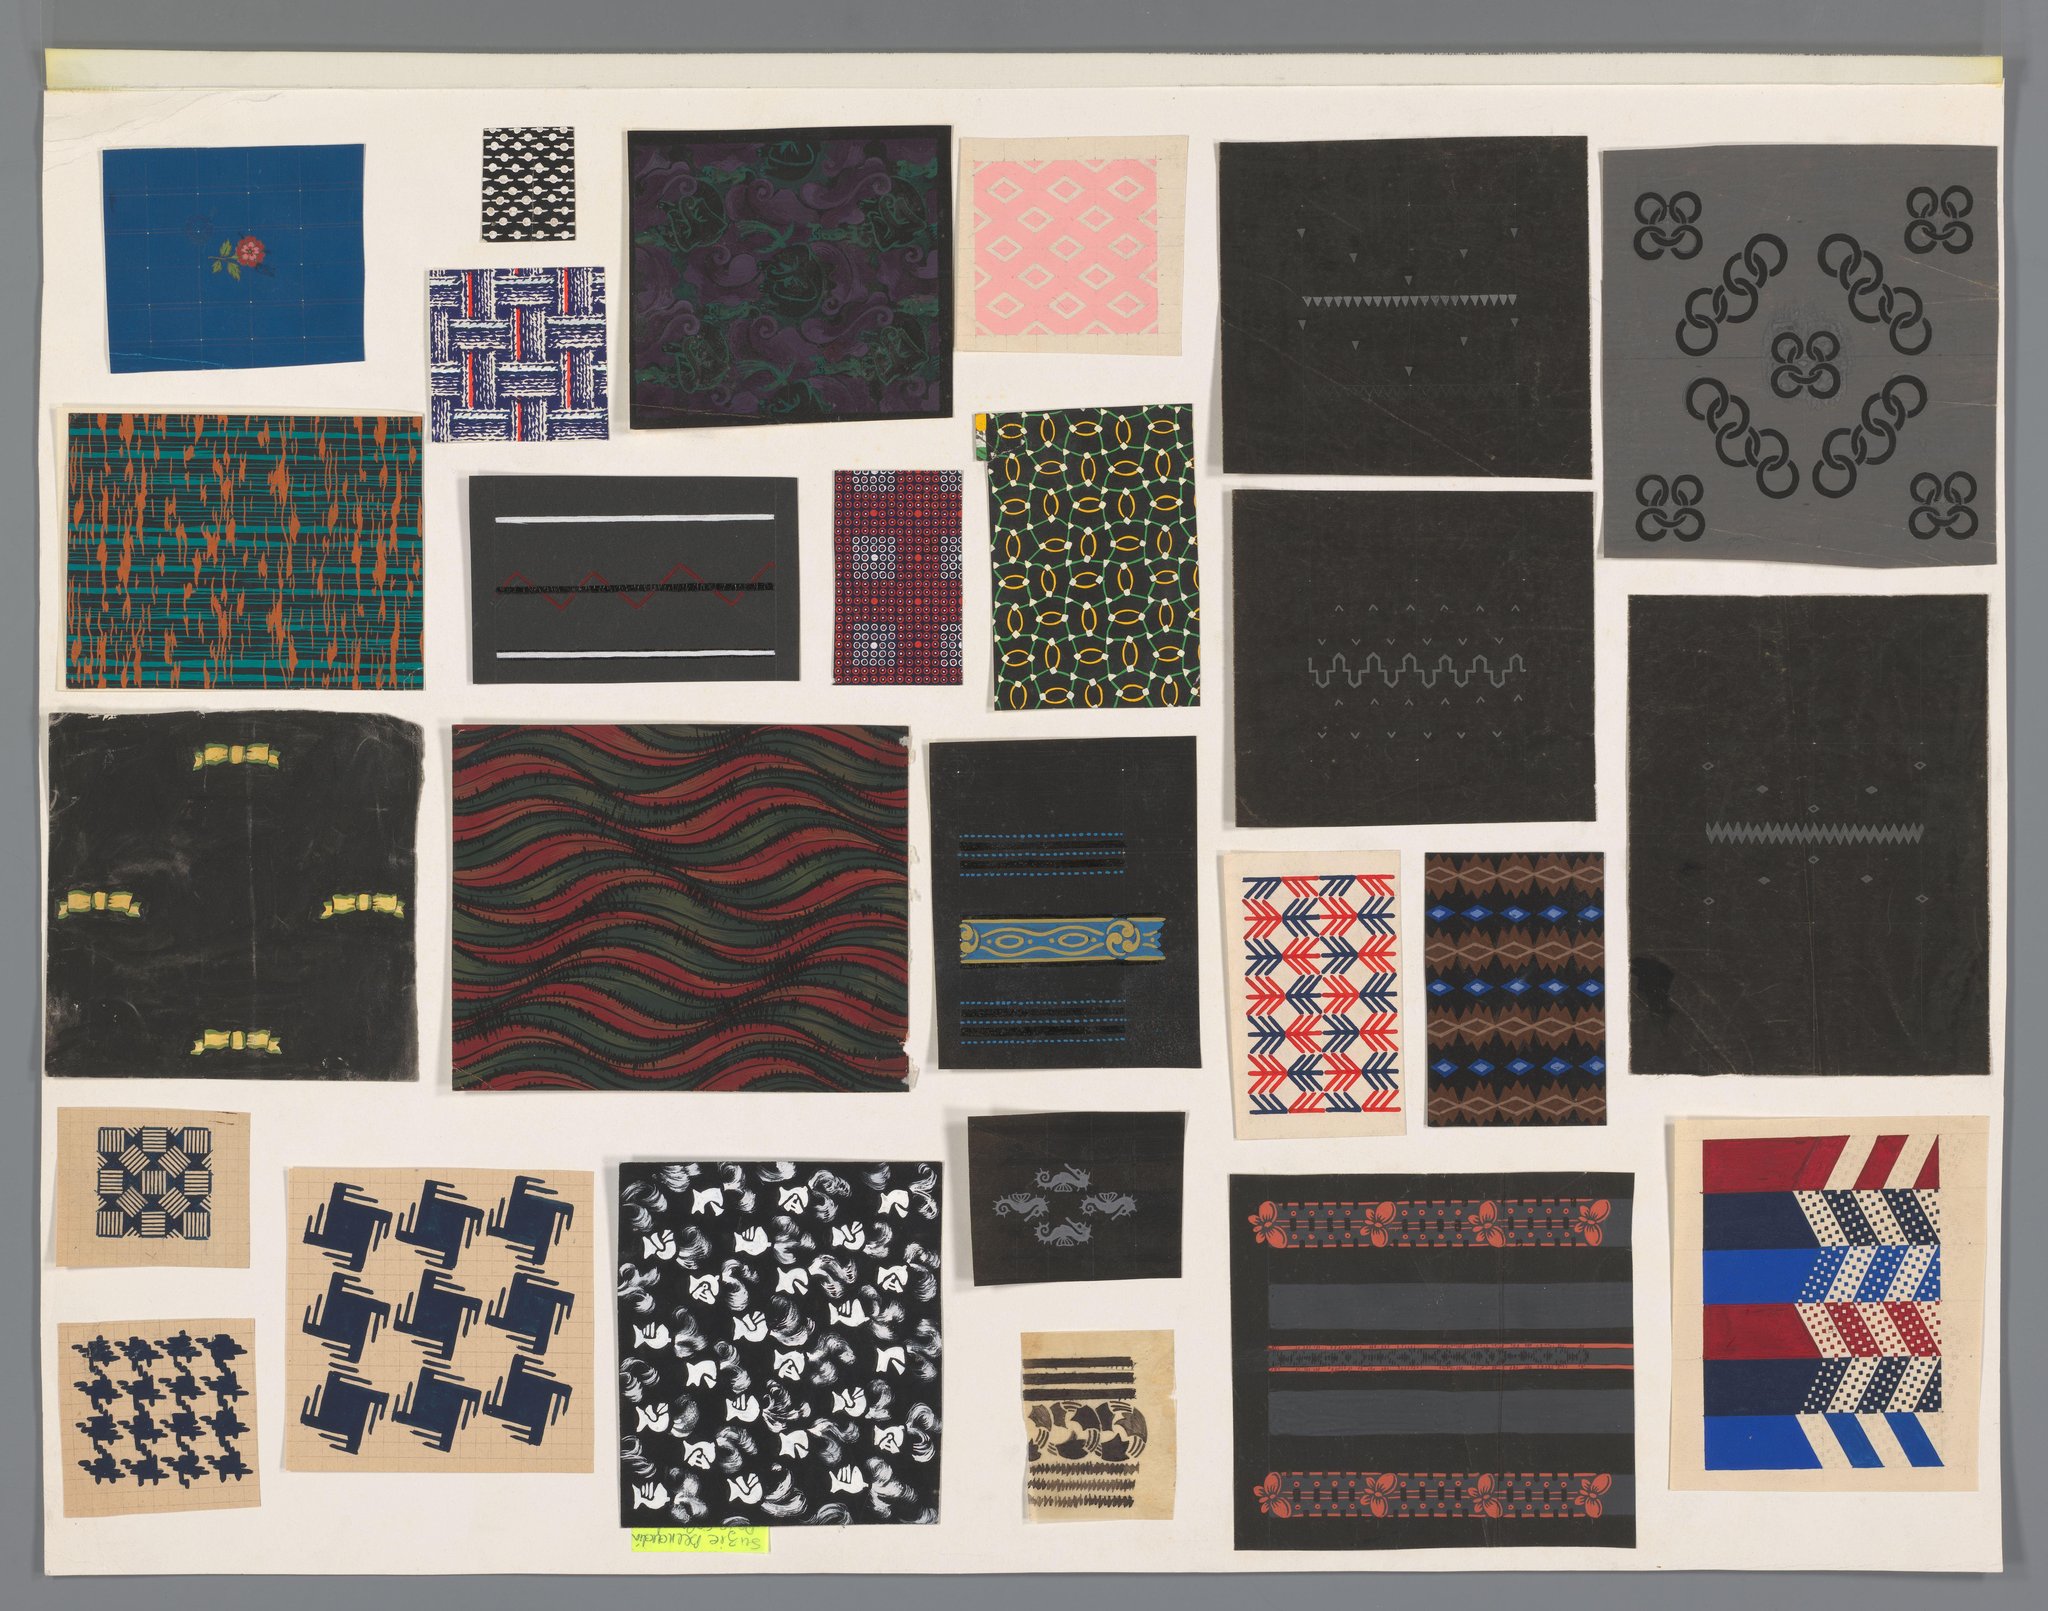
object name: design drawing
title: 26 Ontwerpen voor zijden stoffen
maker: Anonymous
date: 1930-1950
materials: gouache, graphite, paper, plastic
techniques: pasting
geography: lyon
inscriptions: label: ‘Suzie Bernardin / Bois.Colombes’